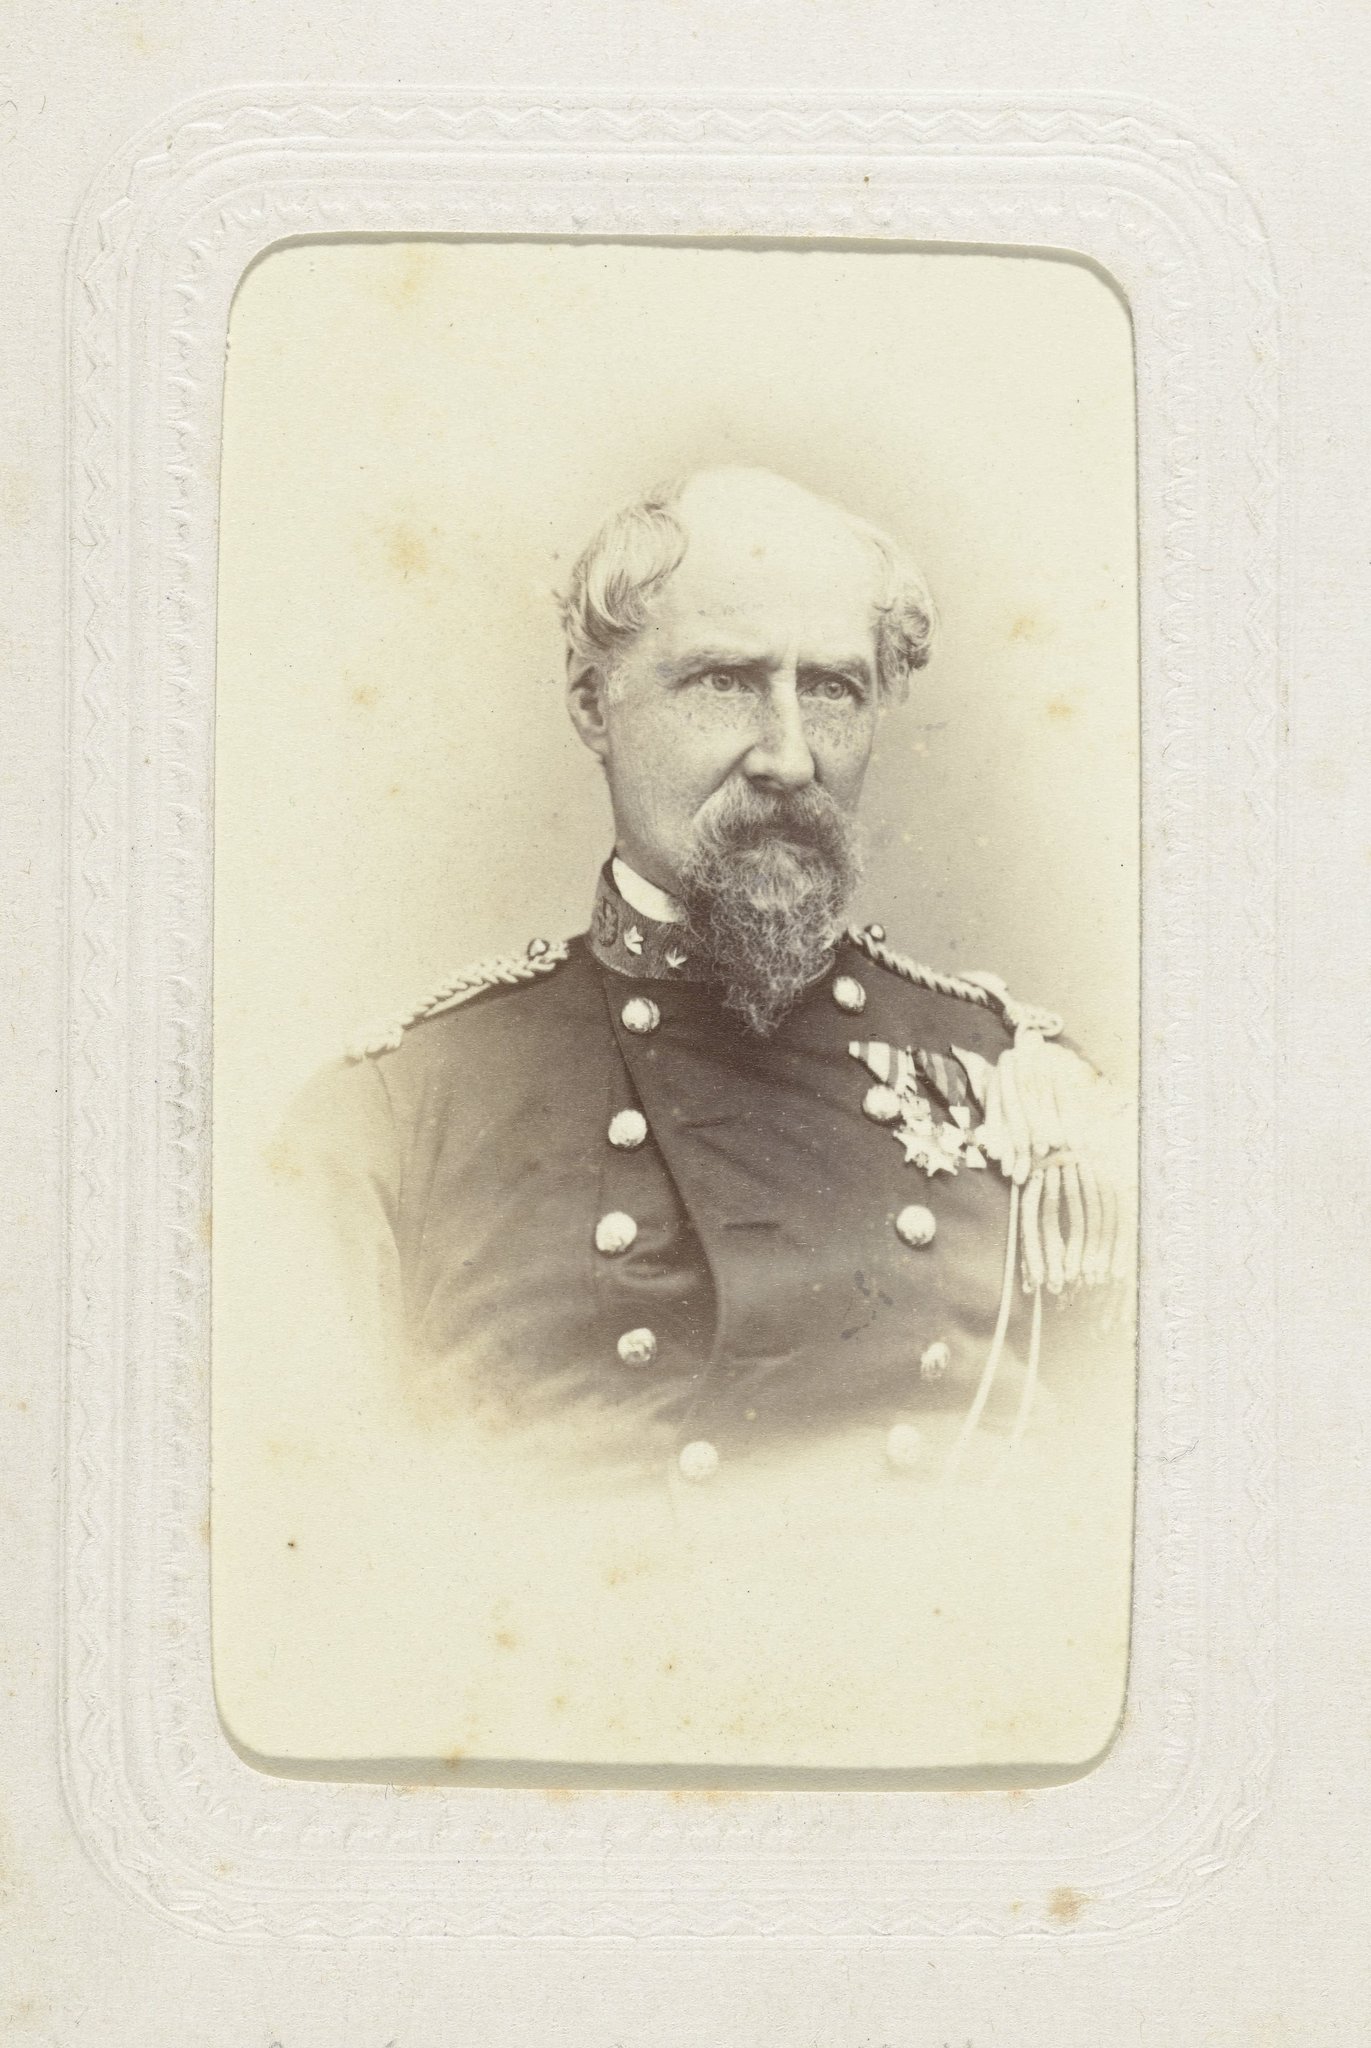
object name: carte de visite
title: Studioportret van generaal-majoor A.M.W van Hasselt met snor en baard in leger uniform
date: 1863-1866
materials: cardboard, paper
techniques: albumen print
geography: amsterdam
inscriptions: title: ‘A.W.M. van Hasselt’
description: Het gaat om generaal-majoor A.M.W van Hasselt, toxicoloog en arts in het Nederlandse leger.